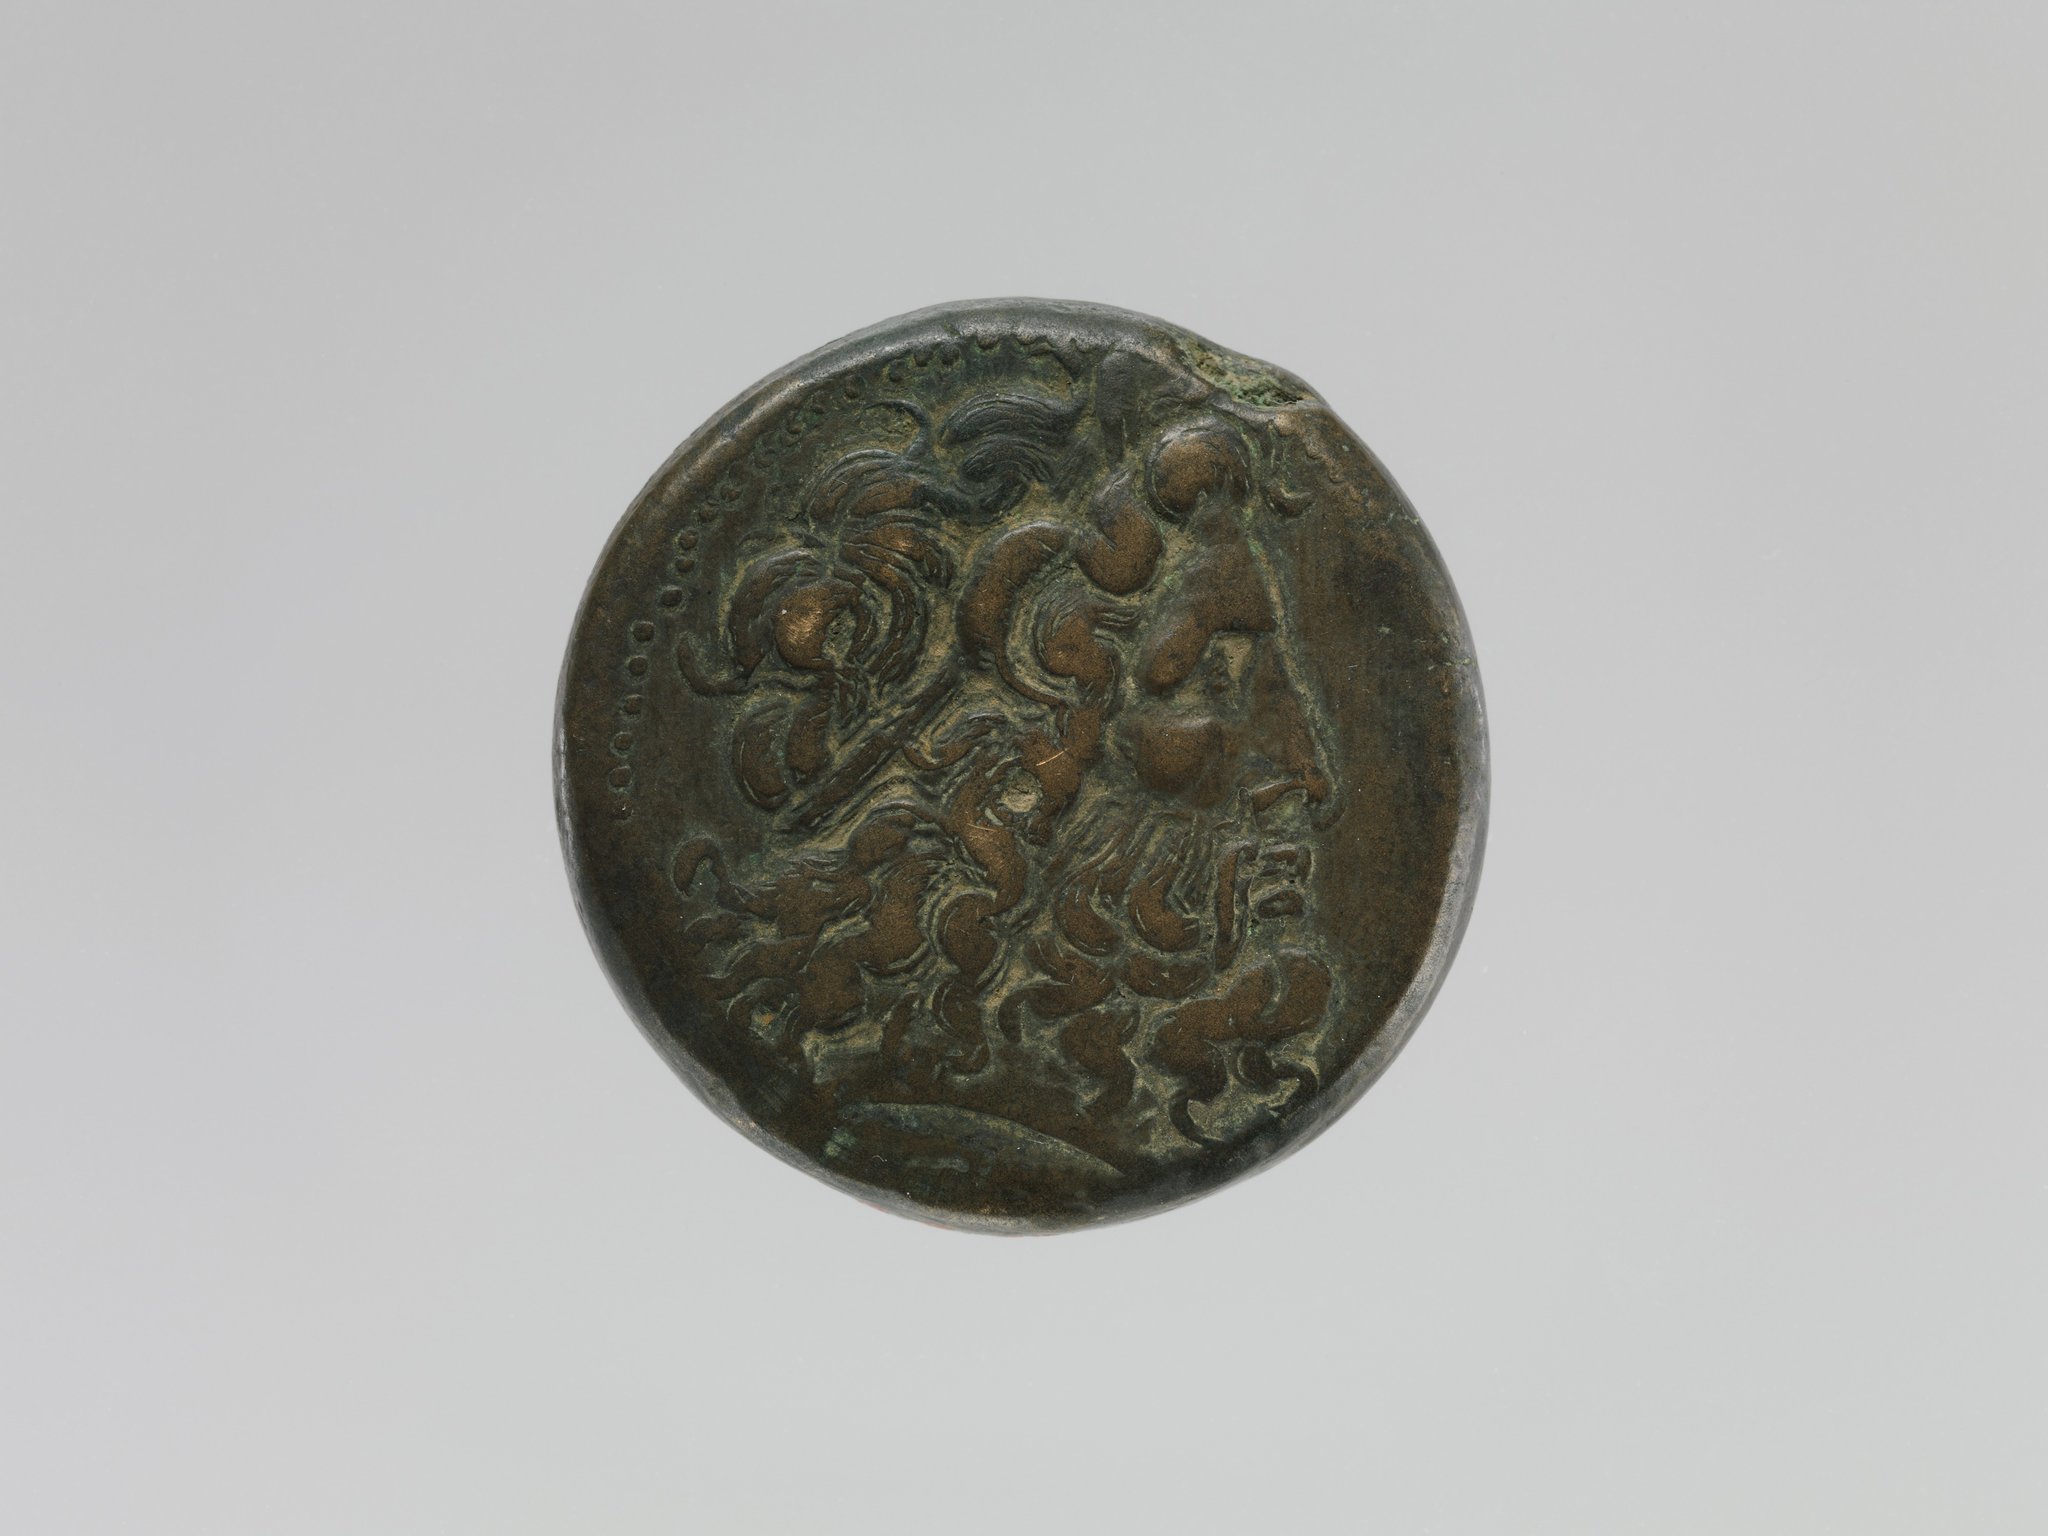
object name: coin, ptolemy ii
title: Coin of Ptolemy II from a Ptolemaic hoard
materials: bronze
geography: egypt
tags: birds,coins